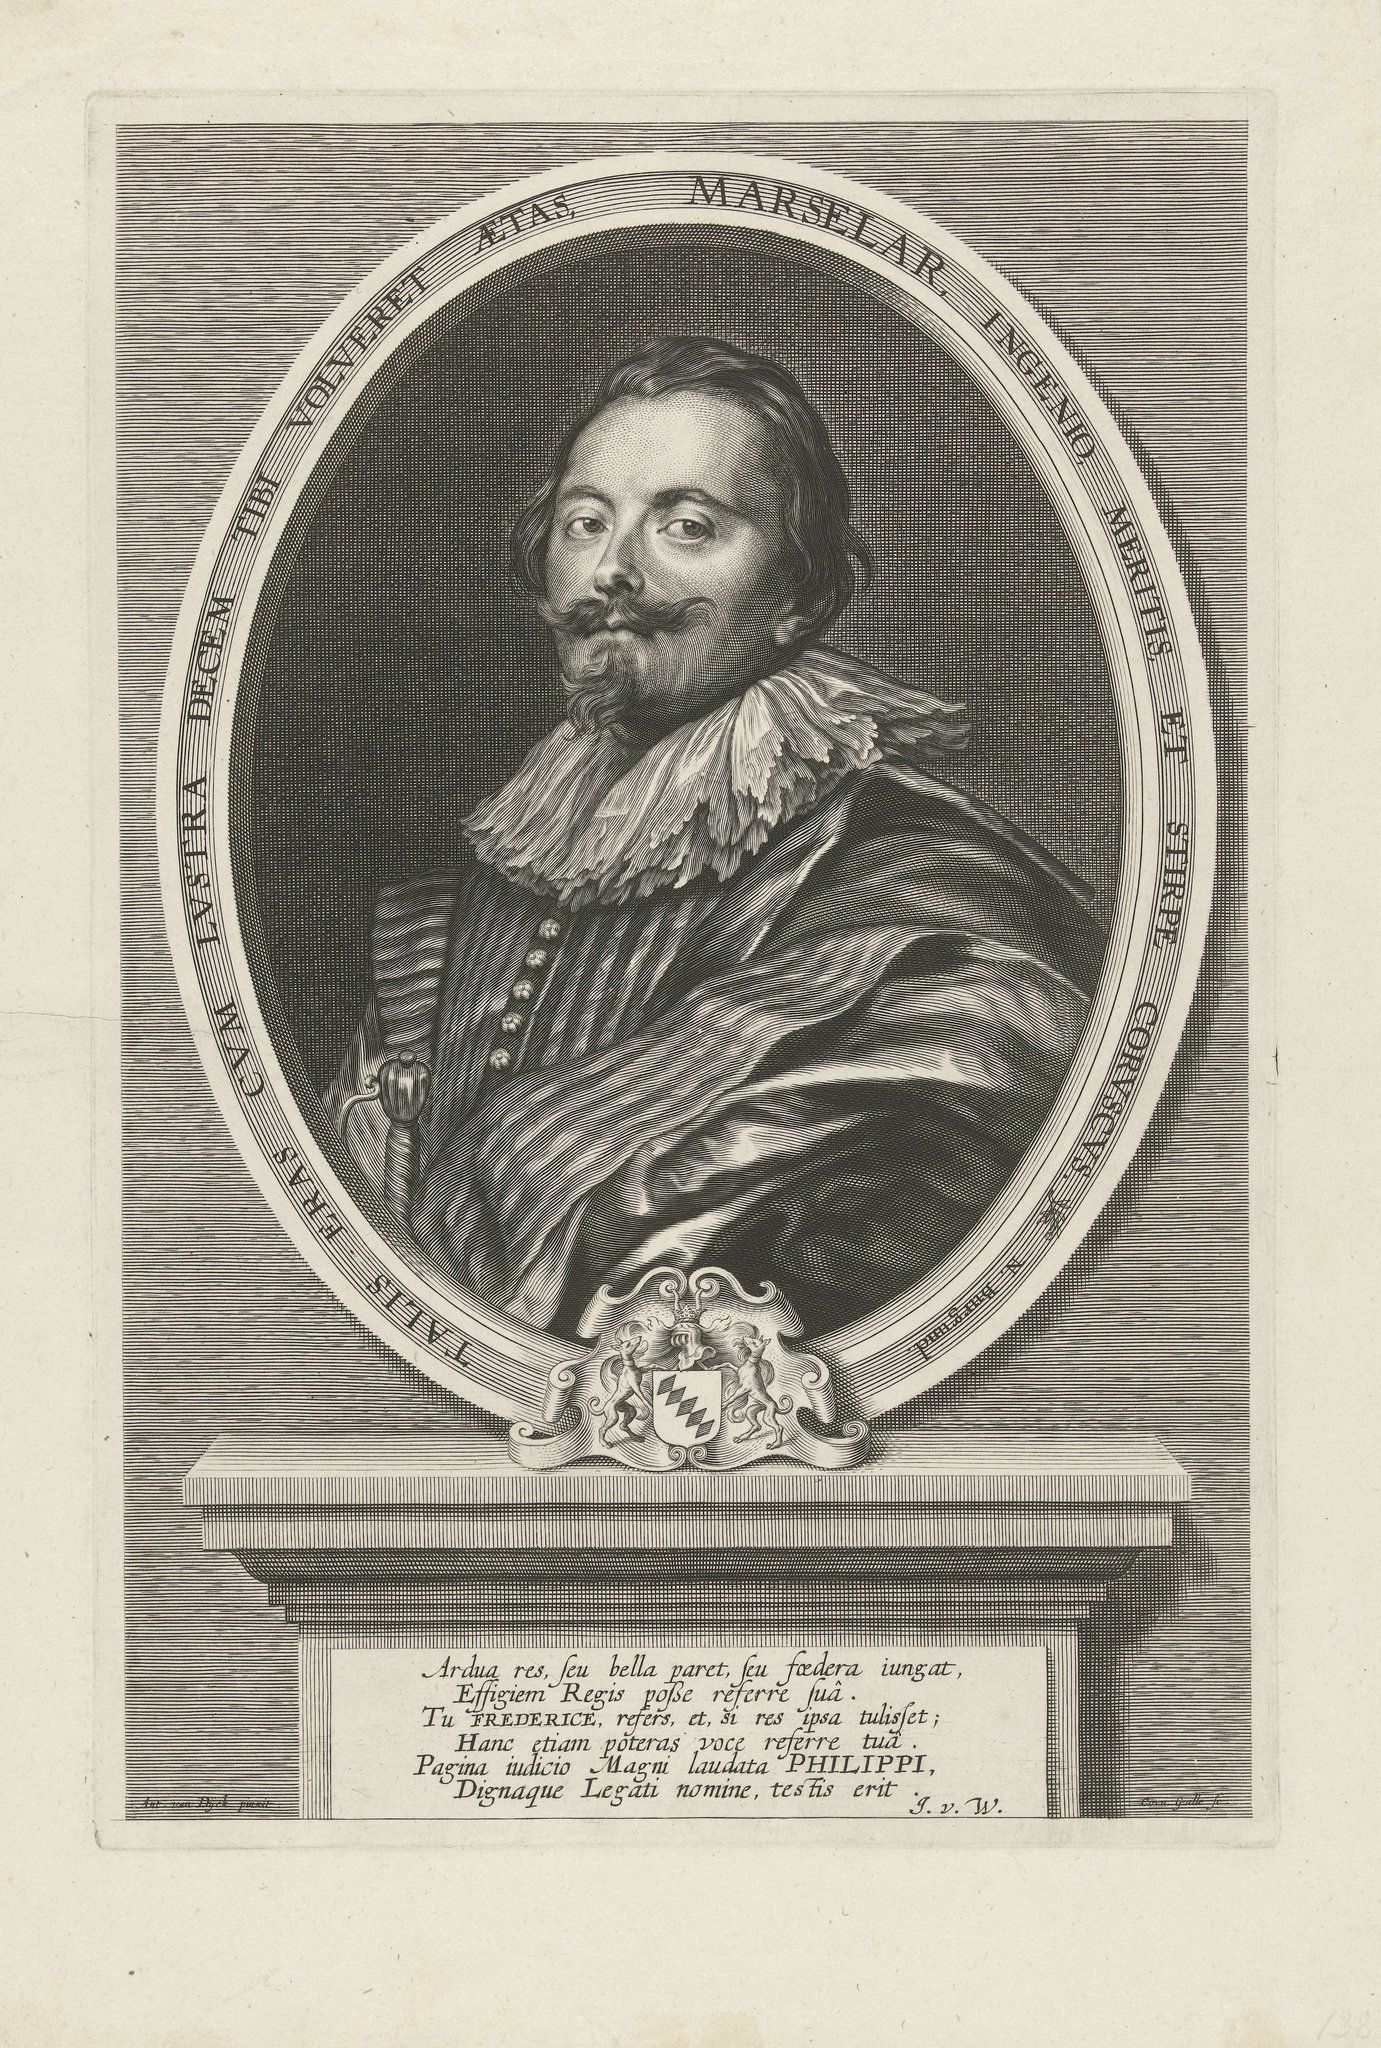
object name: print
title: Portret van Frederick de Marselaer, bestuurder in Brussel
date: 1610-1650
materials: paper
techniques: engraving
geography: southern netherlands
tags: staatsman, frederik de marselaer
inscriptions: collector's mark: Lugt 240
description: Portret van Frederik de Marselaer, in ovaal met randschrift. Op een sokkel een Latijns vers op De Marselaer getekend: I.v.W.